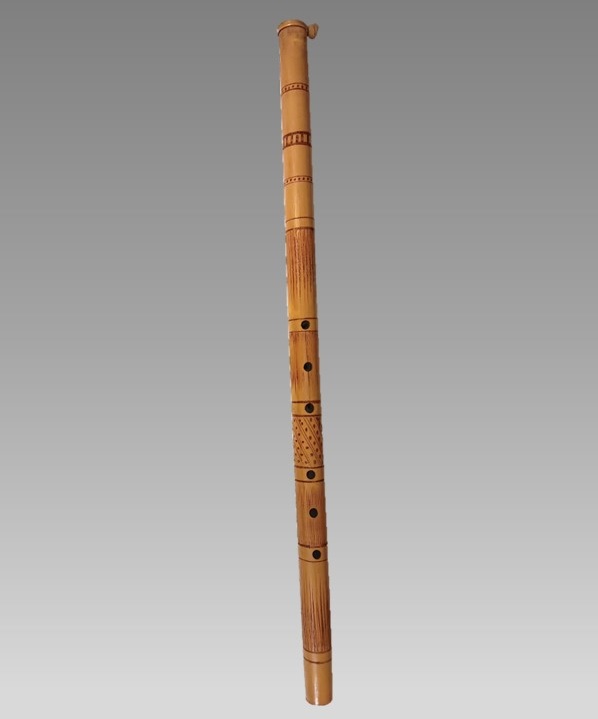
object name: suling ring flute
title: Suling (ring flute)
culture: javanese, sunda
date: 1867-1900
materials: bamboo, rattan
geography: indonesia